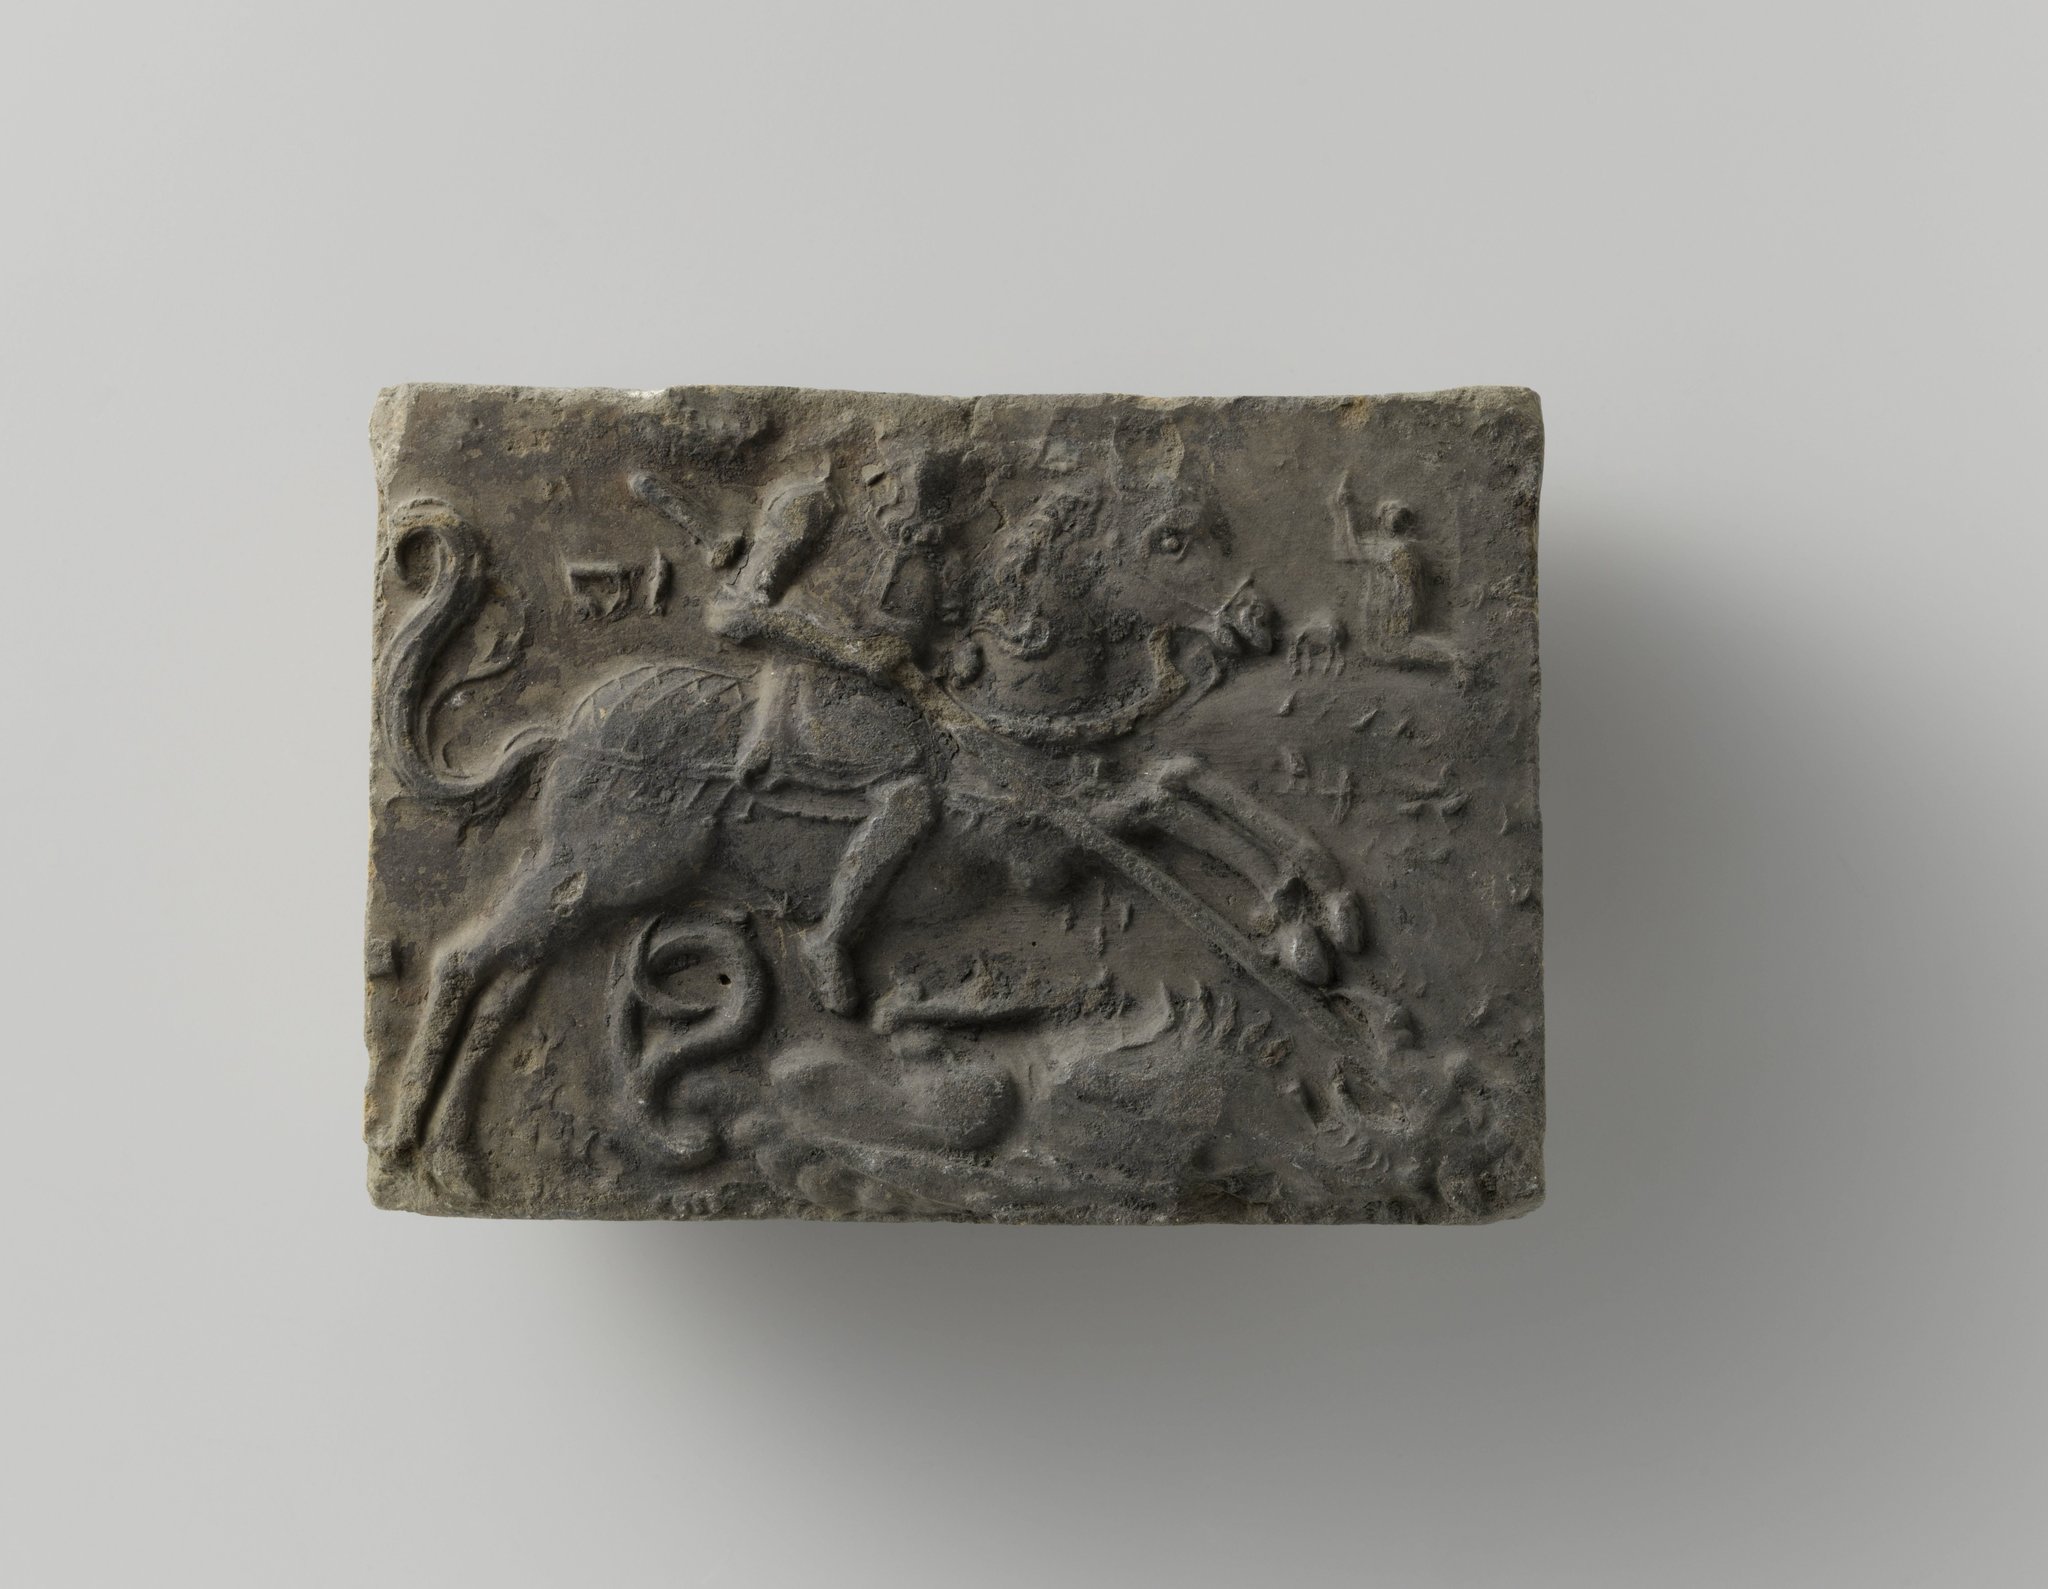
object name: hearthstone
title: Haardsteen met voorstelling van Sint Joris te paard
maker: Anonymous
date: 1525-1575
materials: earthenware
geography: southern netherlands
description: Haardsteen met voorstelling van Sint Joris te paard, met onder hem de verslagen draak liggend op de rug.